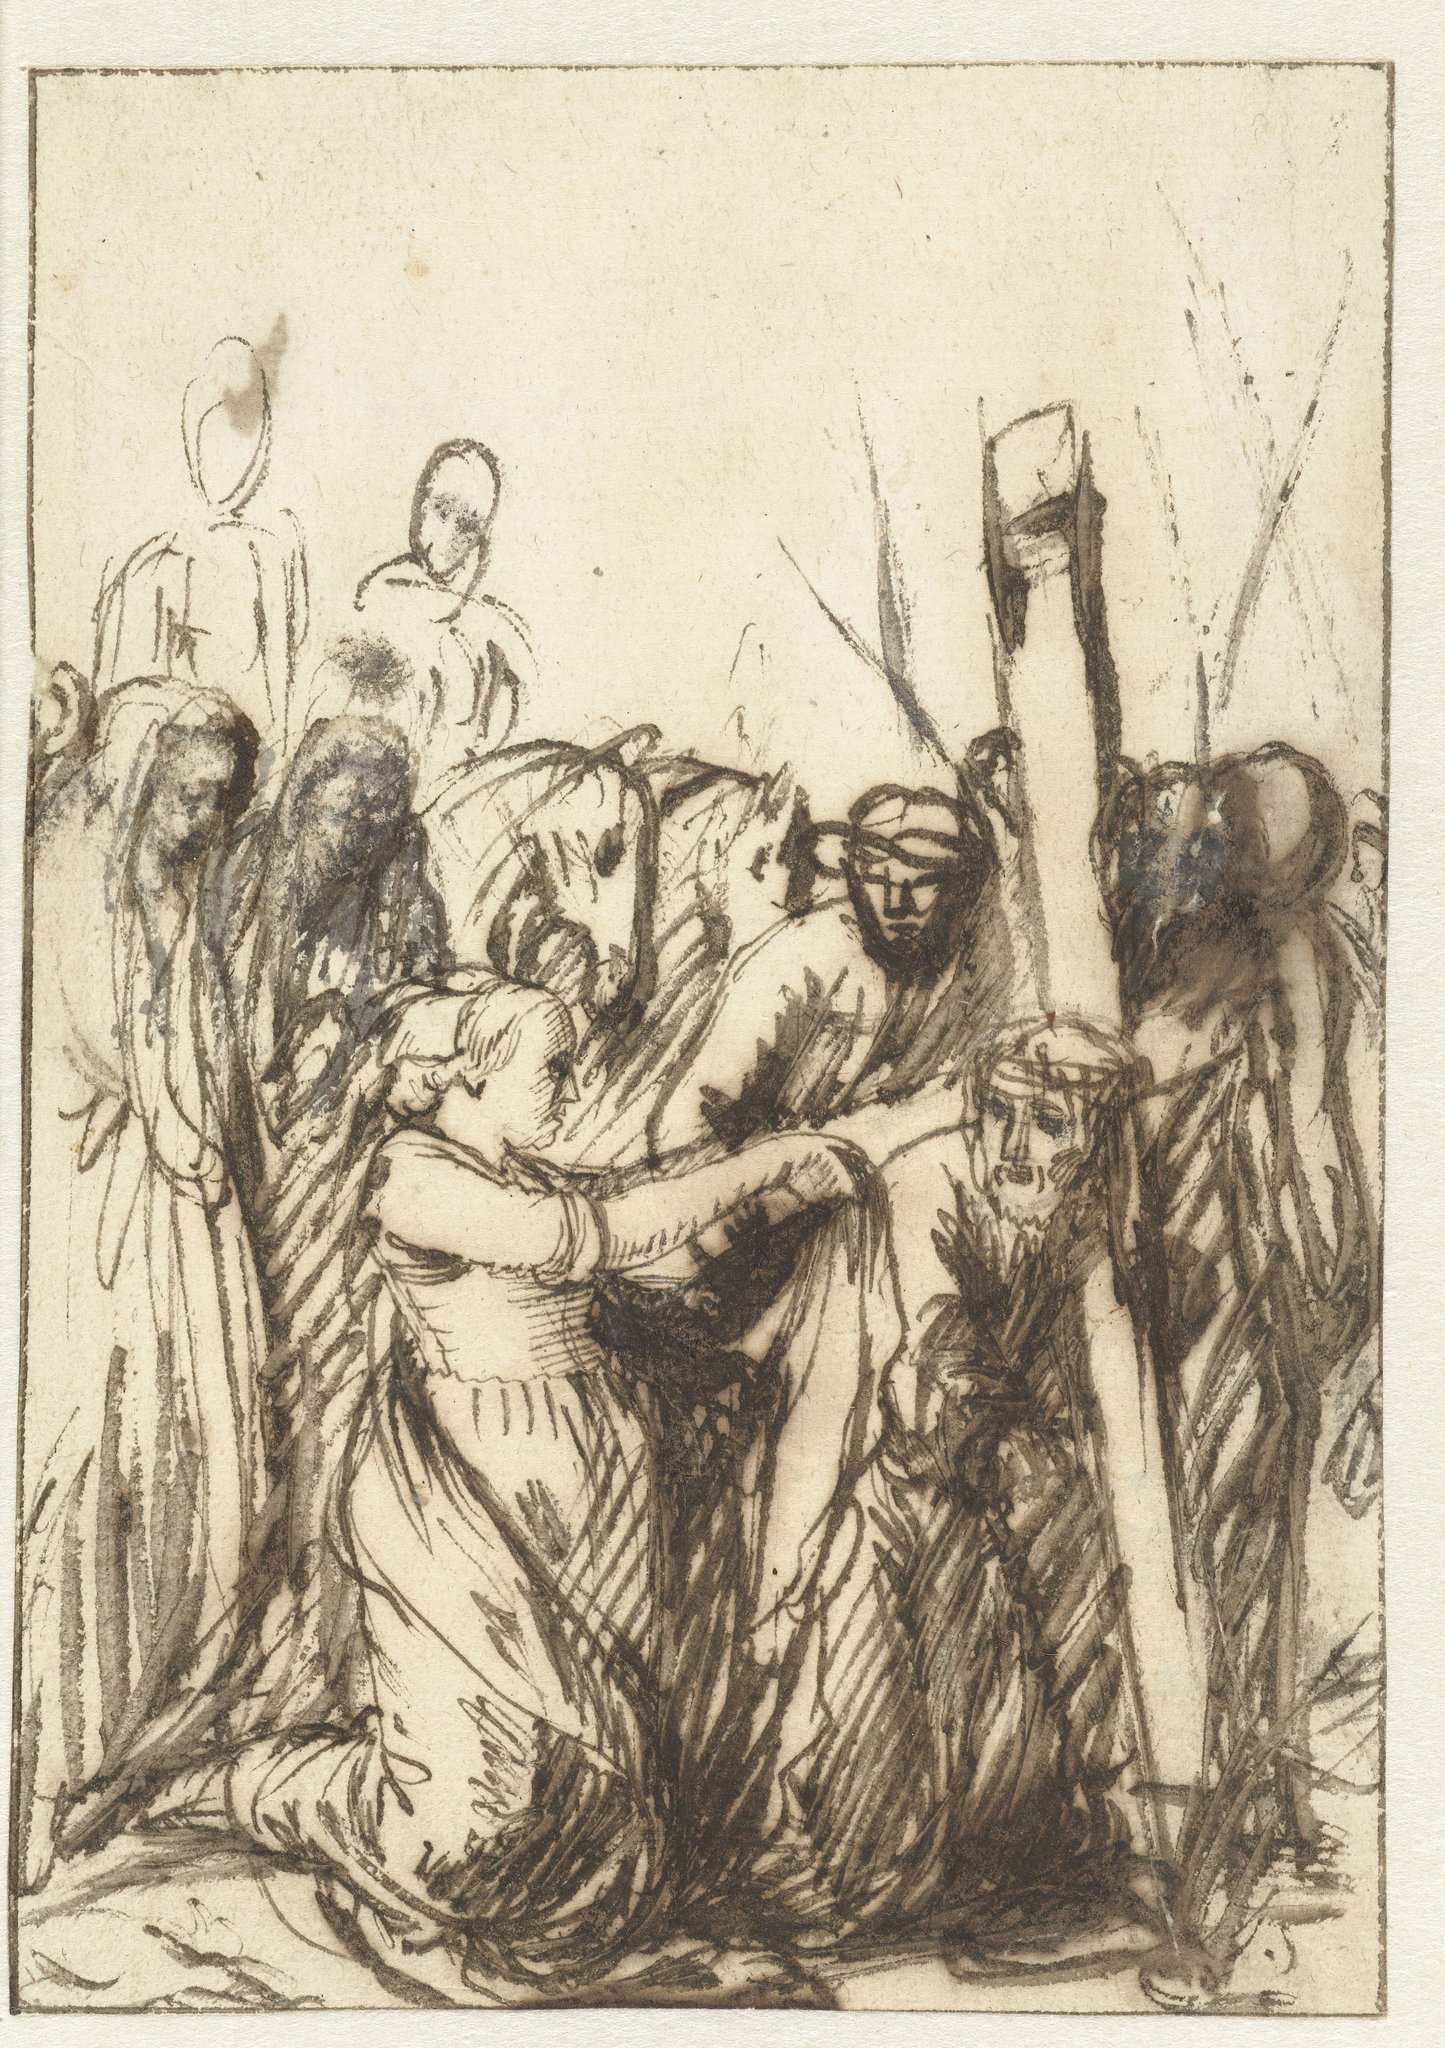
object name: drawing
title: De kruisdraging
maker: hendrick goudt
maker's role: draughtsman, print maker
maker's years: 1581-1648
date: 1580-1650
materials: ink, paper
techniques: brush, pen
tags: christ meets veronica, who has a cloth to wipe christ's face